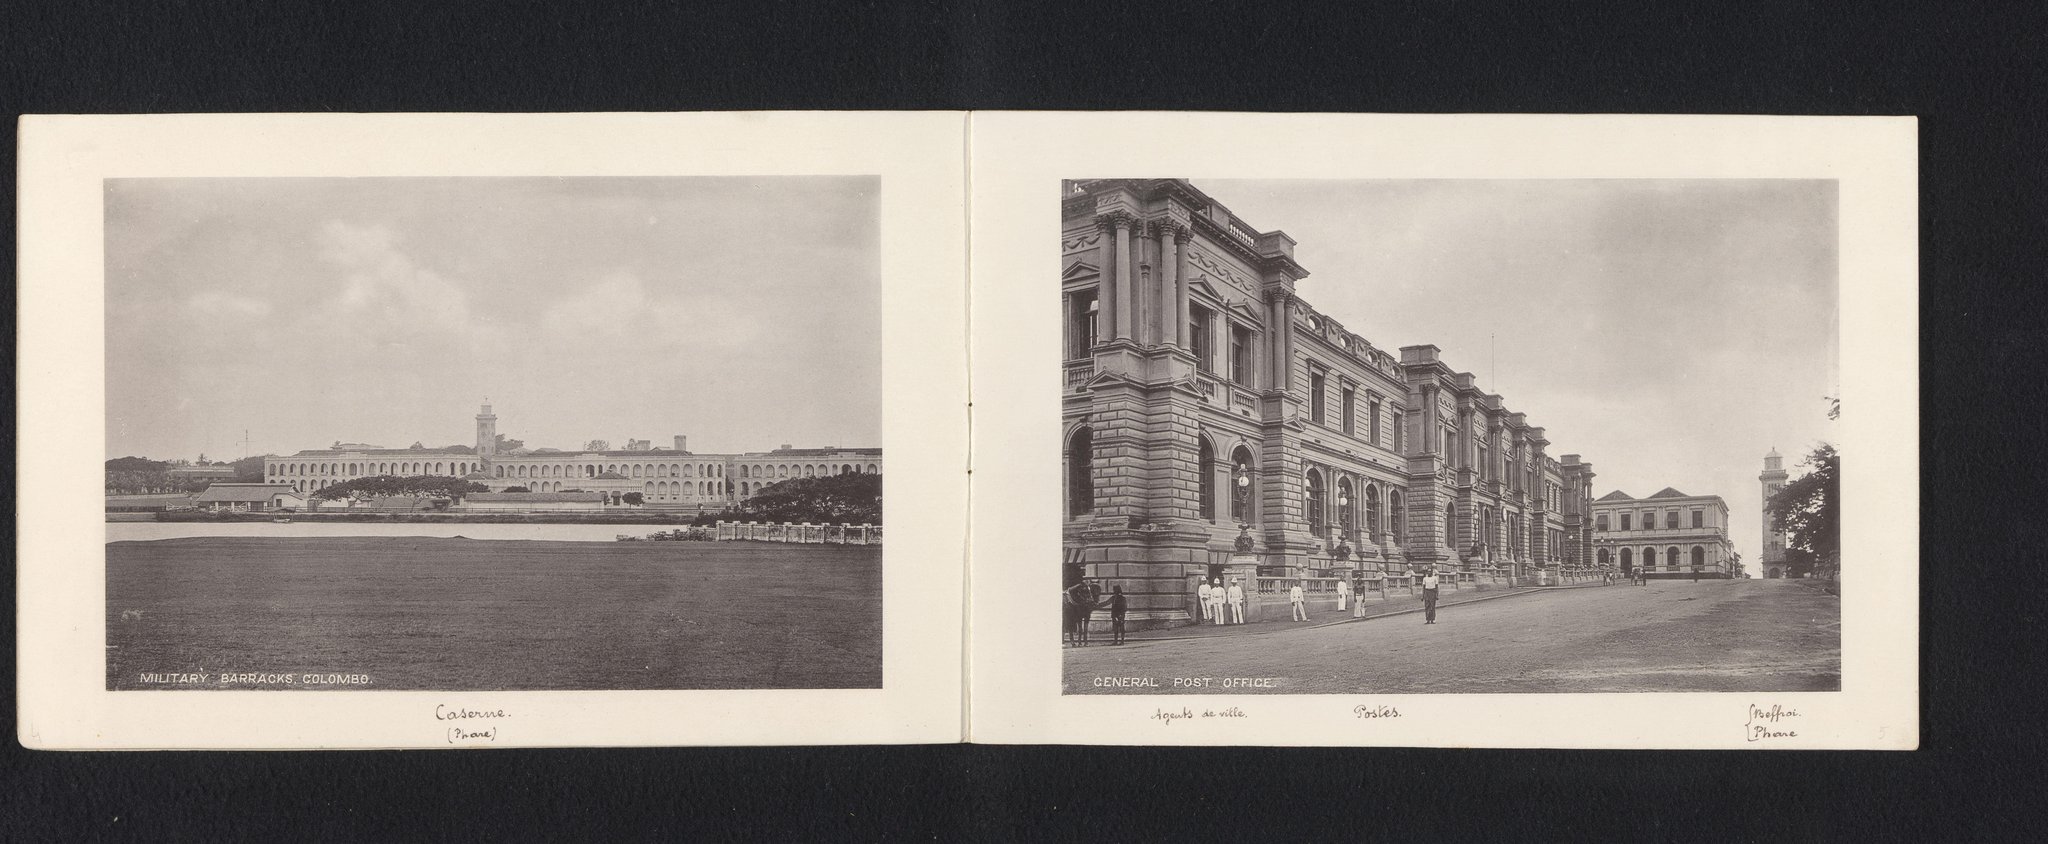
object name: page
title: Gezicht op militaire barakken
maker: henry william cave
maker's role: fotograaf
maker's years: 1854-1913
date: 1890-1910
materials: paper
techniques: photograph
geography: colombo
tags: barracks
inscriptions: inscription: ‘Caserne (Phare)’